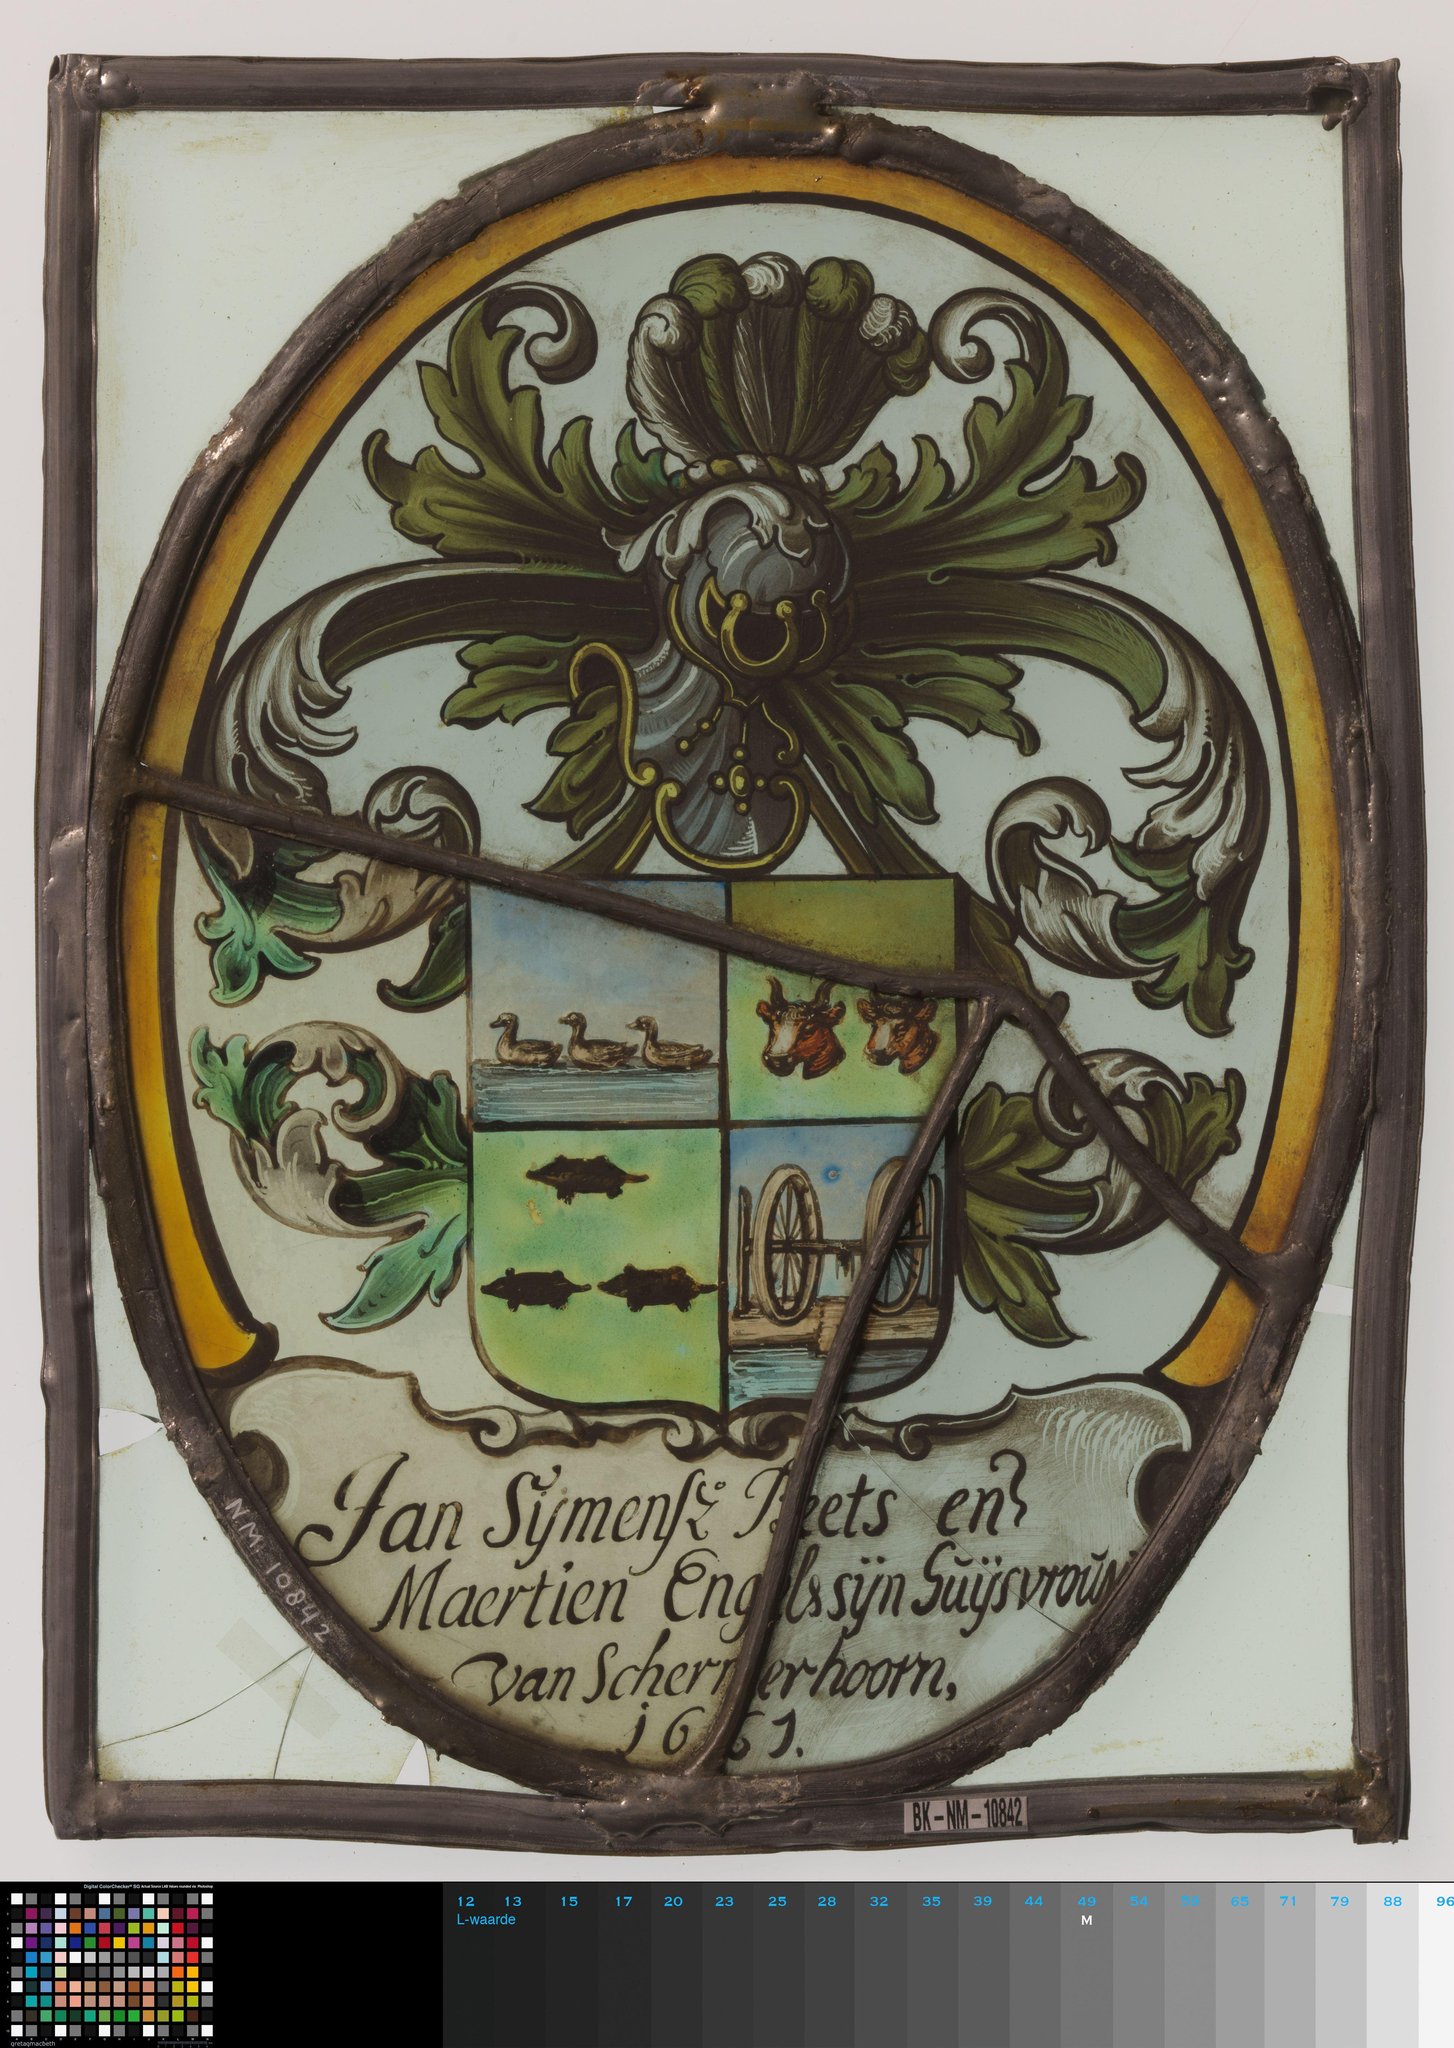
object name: wapenruit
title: Ruit met het wapen van Jan Symensz. Beets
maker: Anonymous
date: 1661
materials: glass, lead, pigment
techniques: leading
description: Een gebrande ovale ruit met het wapen van Jan Symensz. Beets.